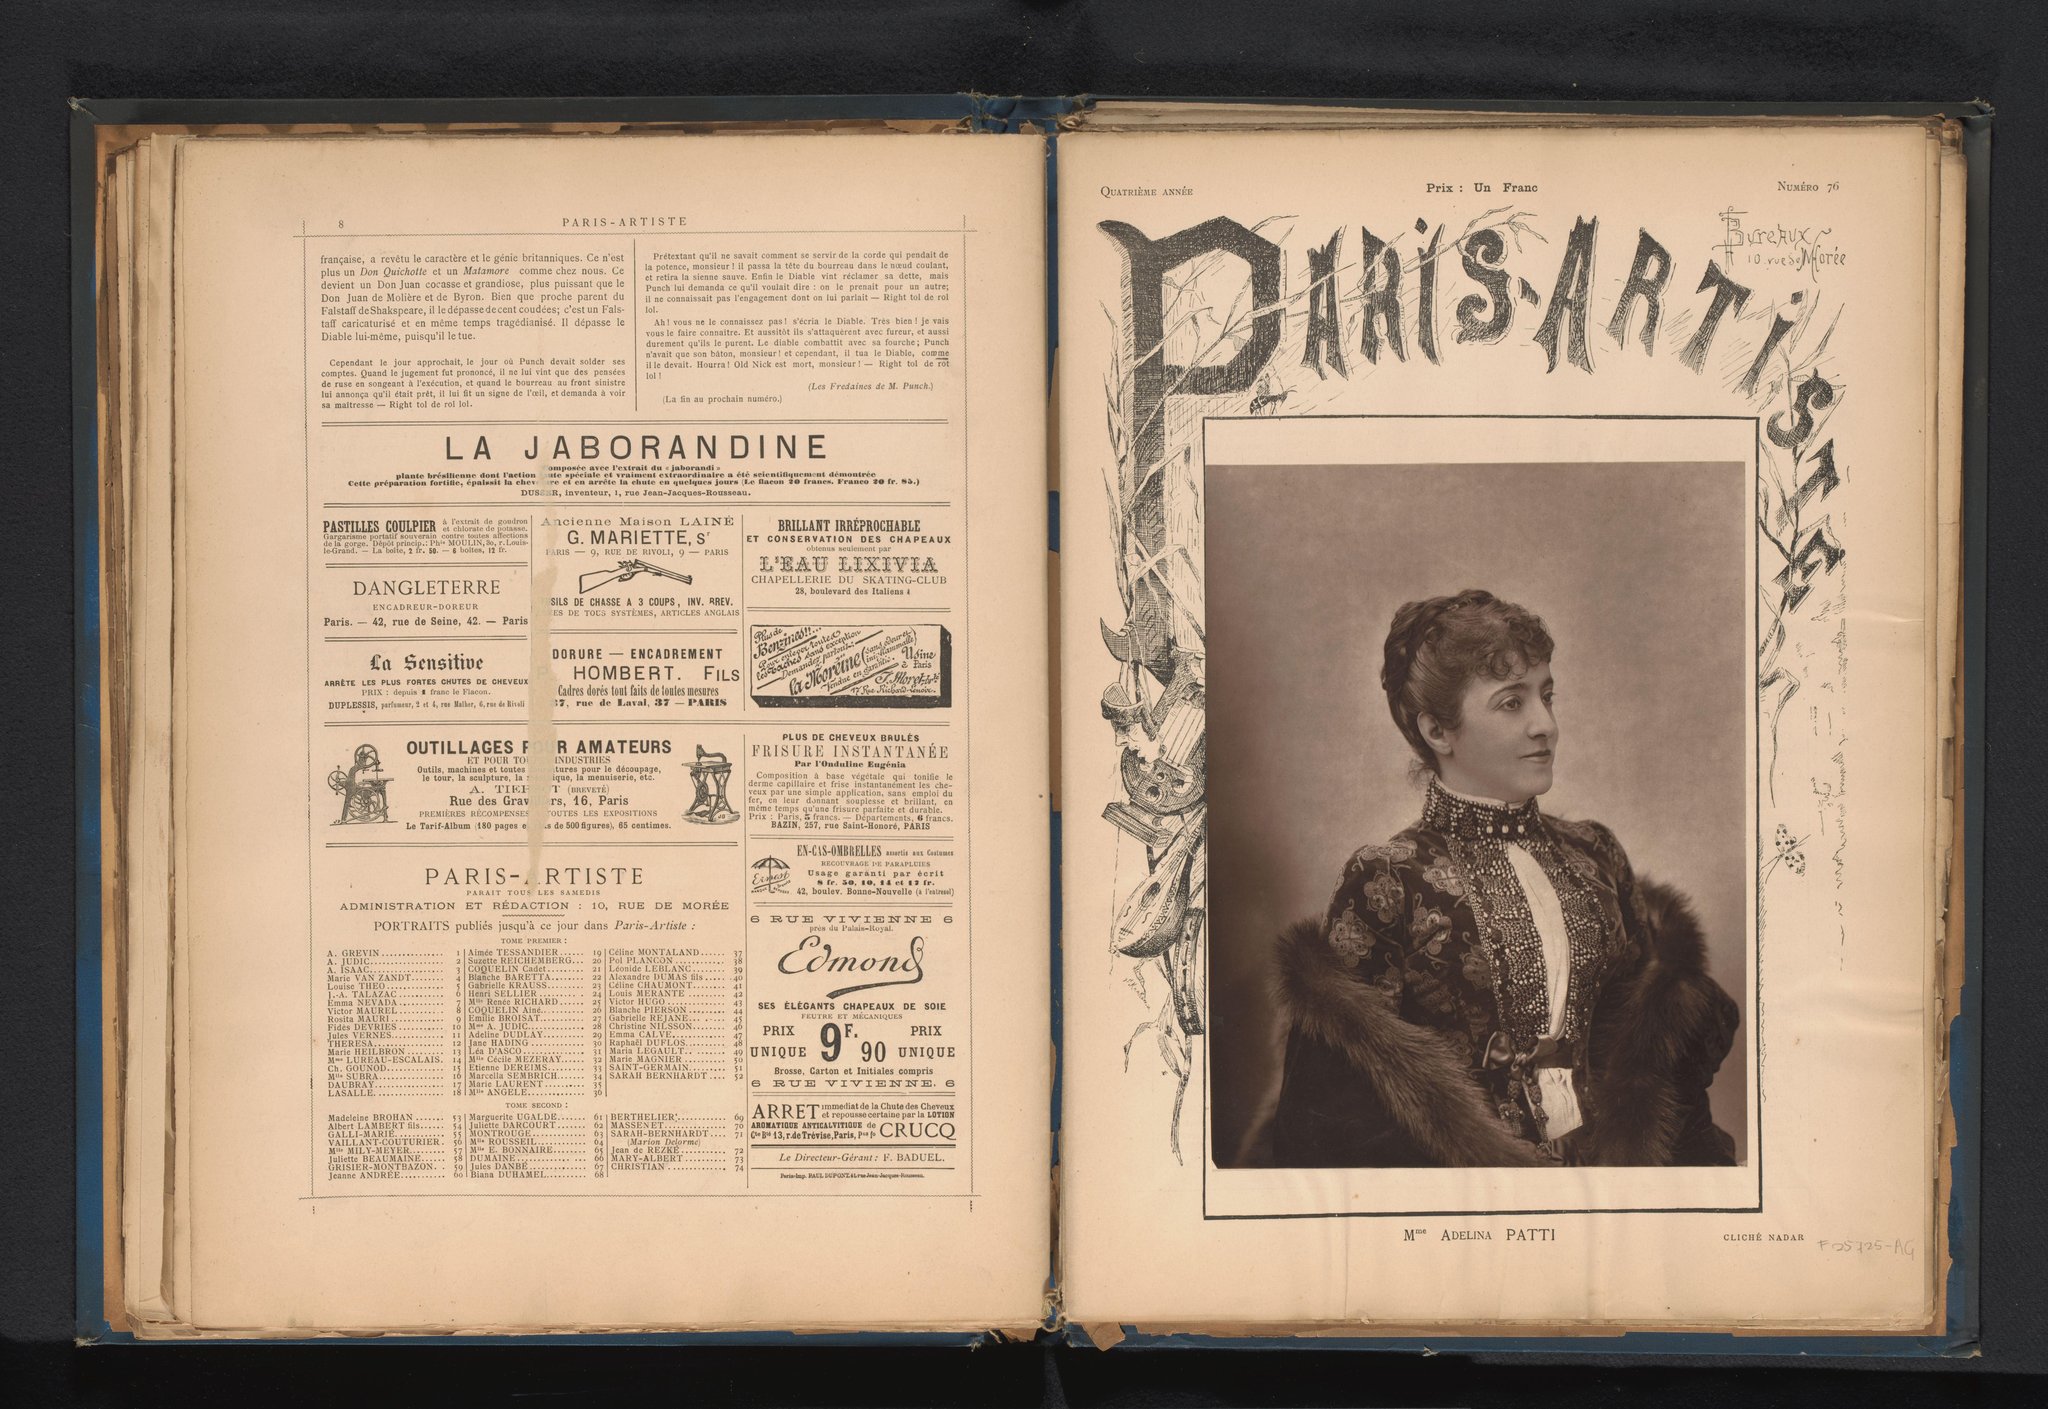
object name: page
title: Portret van Adelina Patti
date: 1880-1886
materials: paper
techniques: woodburytype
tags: historical persons - bb - woman, female singer